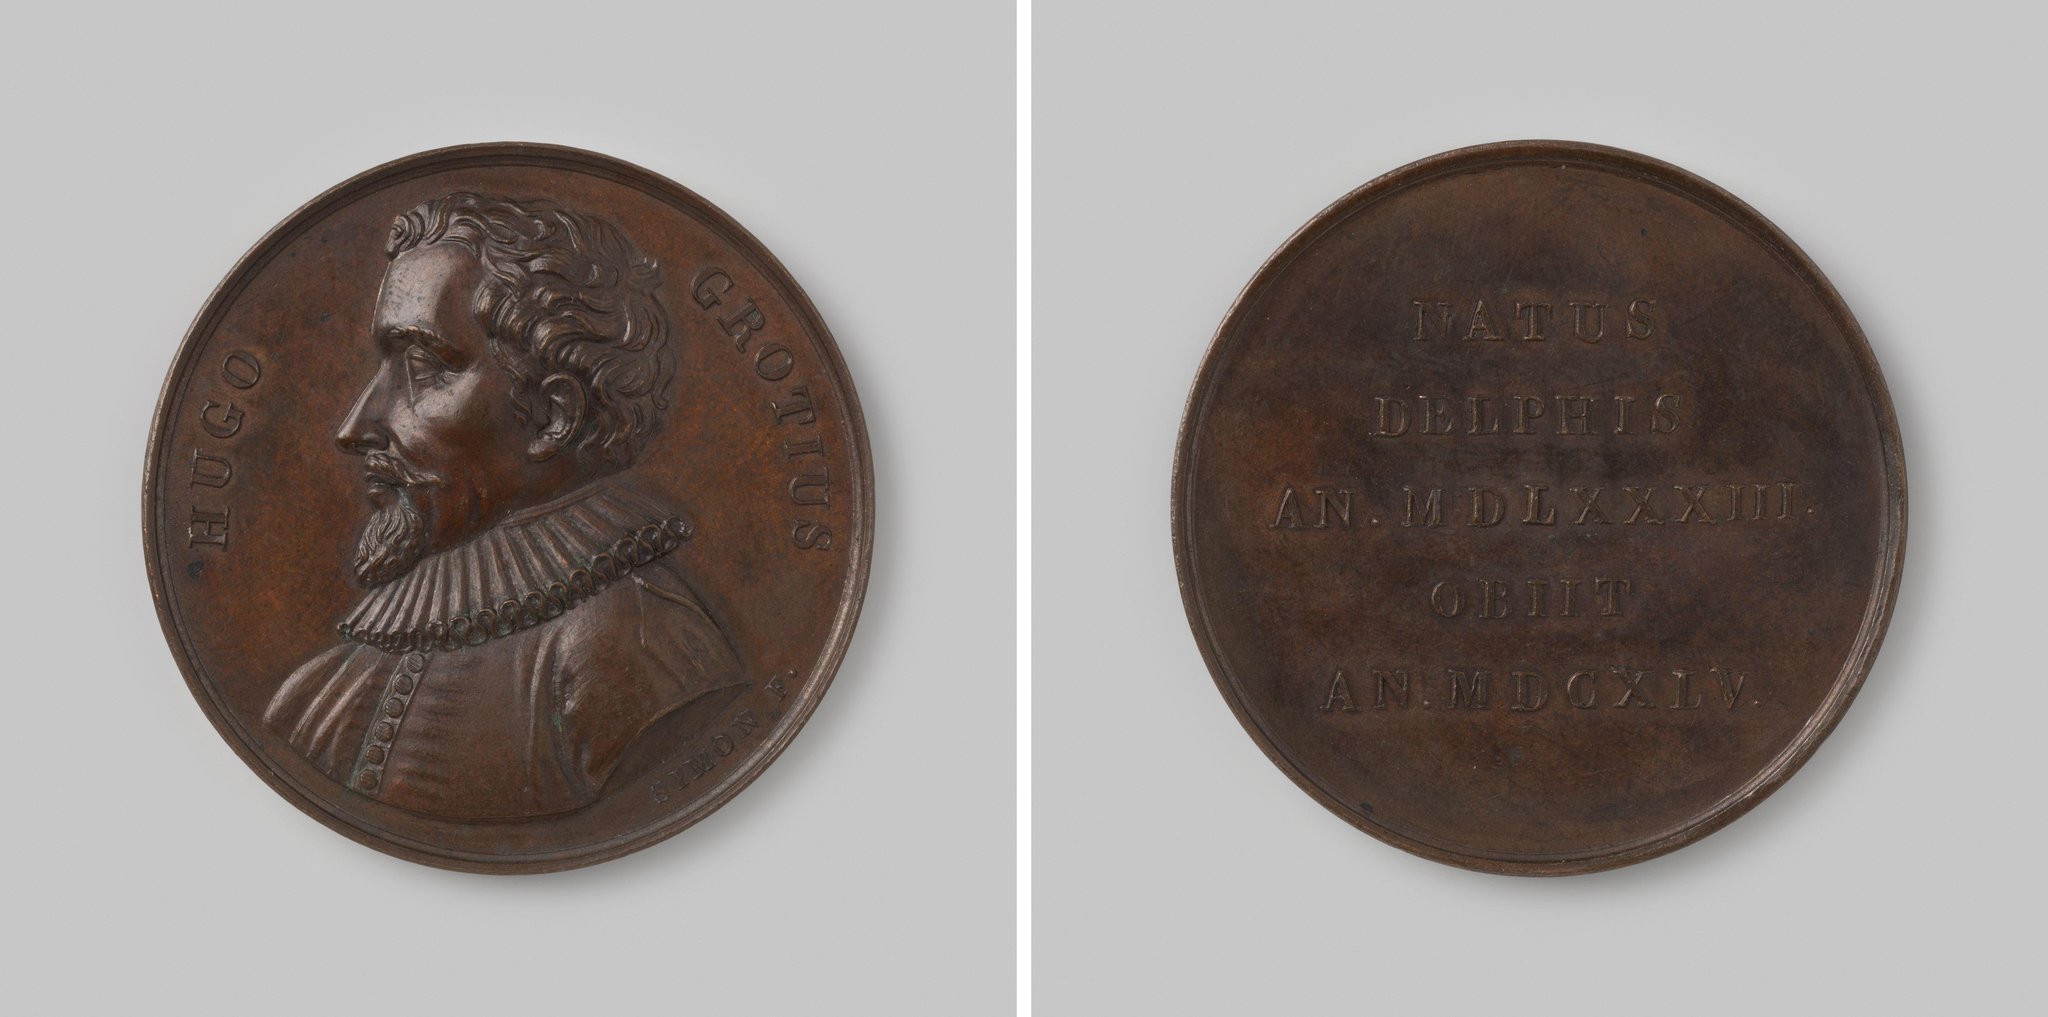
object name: history medal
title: Hugo de Groot 1583-1645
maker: simon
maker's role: publisher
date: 1815-1830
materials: copper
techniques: striking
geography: brussels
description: Koperen penning, op de voorzijde het portret van De Groot naar links met Latijns omschrift, op de keerzijde vijf regels tekst